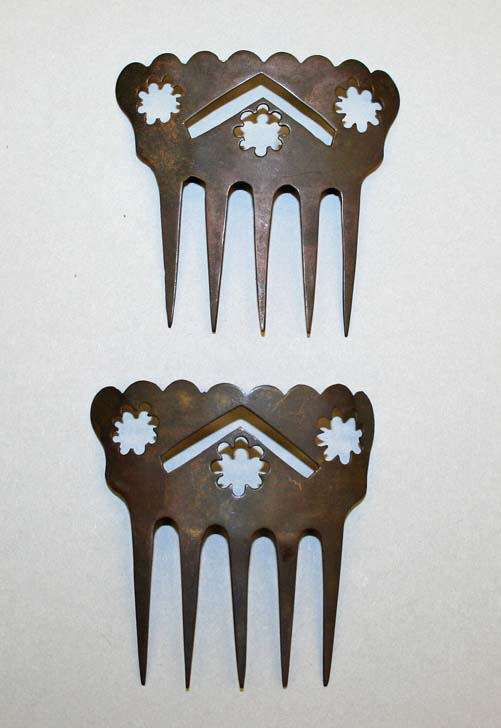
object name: comb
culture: spanish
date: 1801-1900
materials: brass